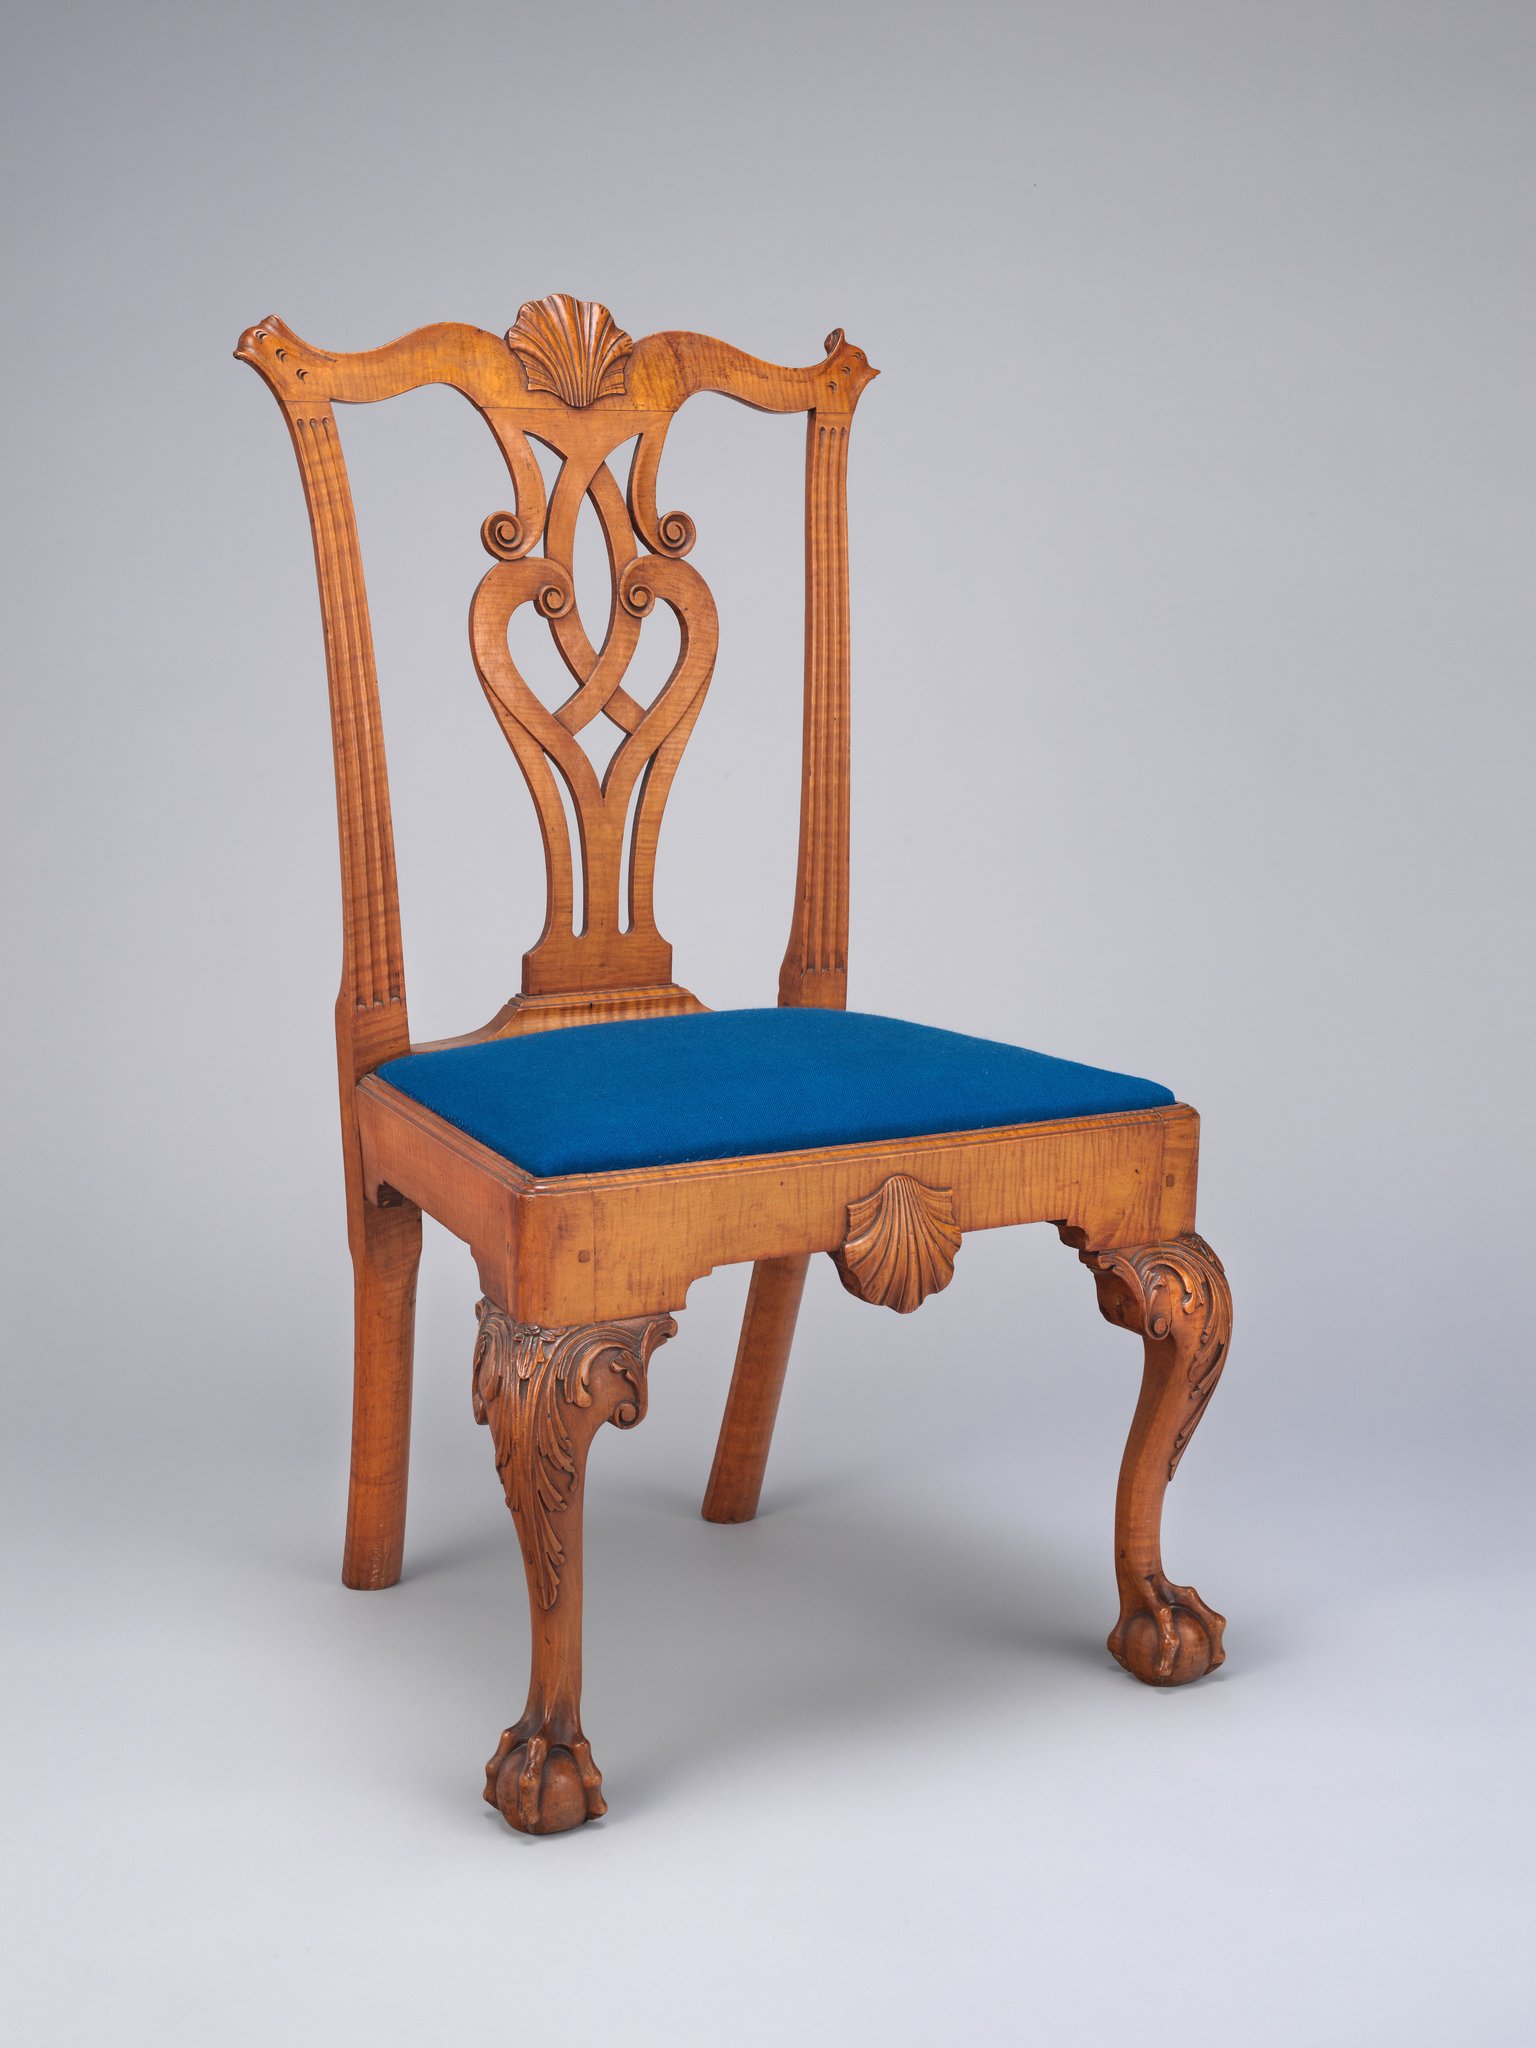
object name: side chair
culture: american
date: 1755-1790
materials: wood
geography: united states